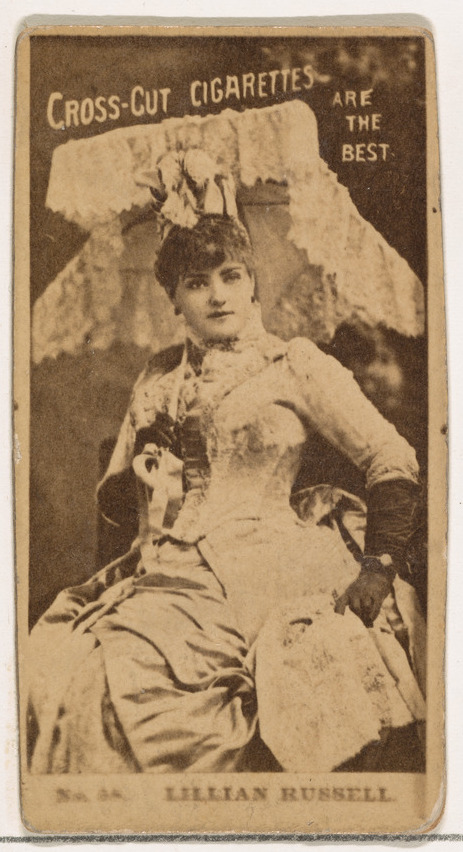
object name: print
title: Lillian Russell, from the Actors and Actresses series (N145-2) issued by Duke Sons & Co. to promote Cross Cut Cigarettes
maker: w. duke, sons & co.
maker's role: publisher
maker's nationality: american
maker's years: 1870-1920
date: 1880-1889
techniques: albumen silver print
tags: portraits,women,actresses